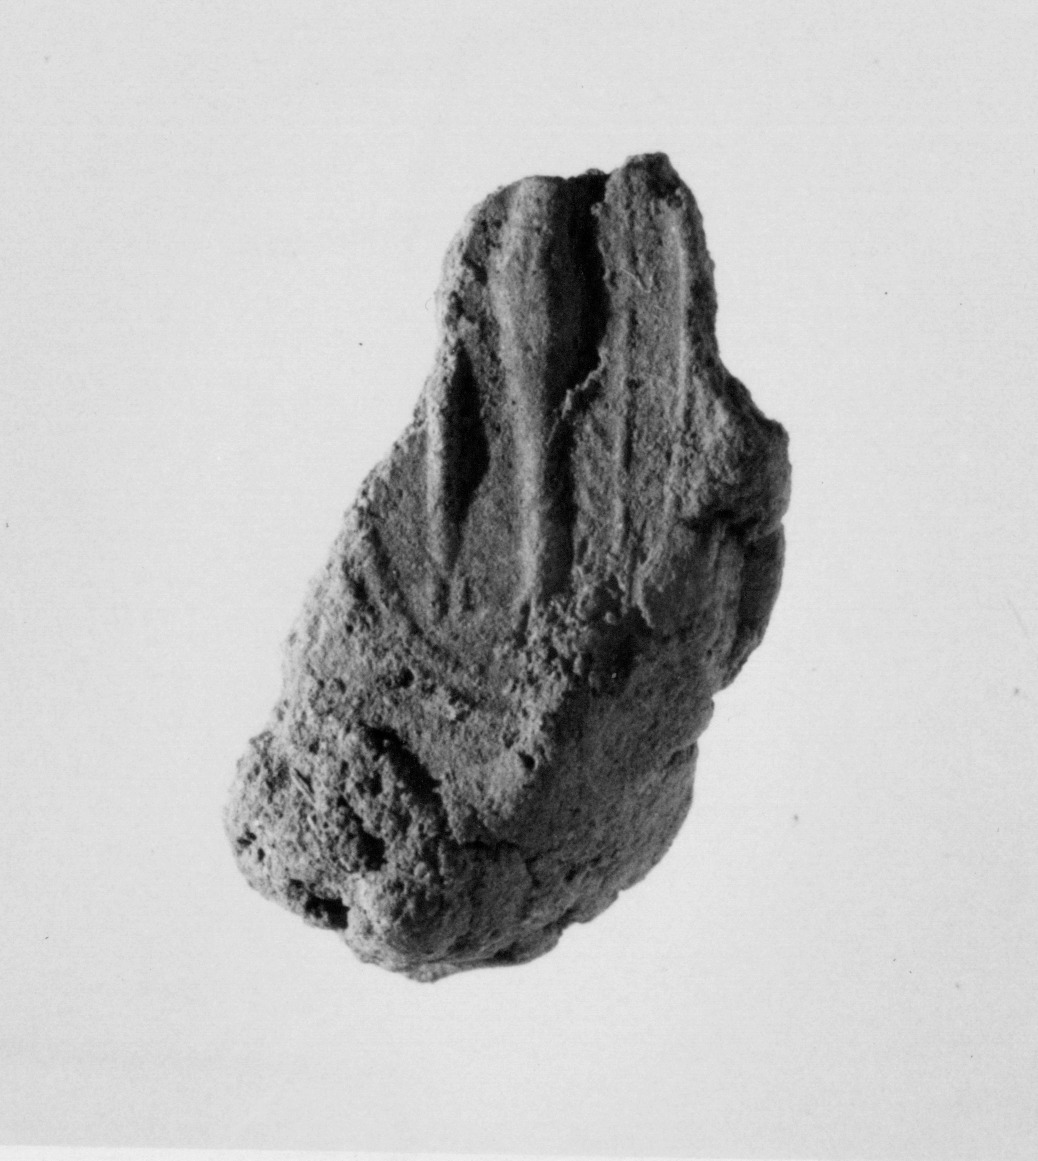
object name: sealing, ptah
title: Document Sealing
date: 1390-1352 BCE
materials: mud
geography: egypt